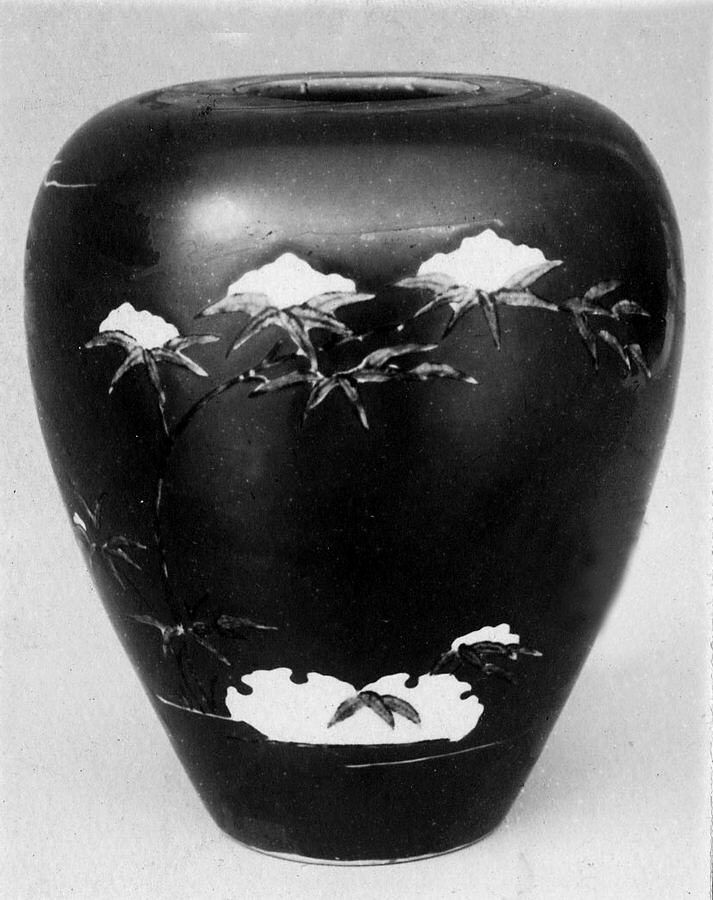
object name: flower vase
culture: japanese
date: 1780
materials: glaze, porcelain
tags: leaves